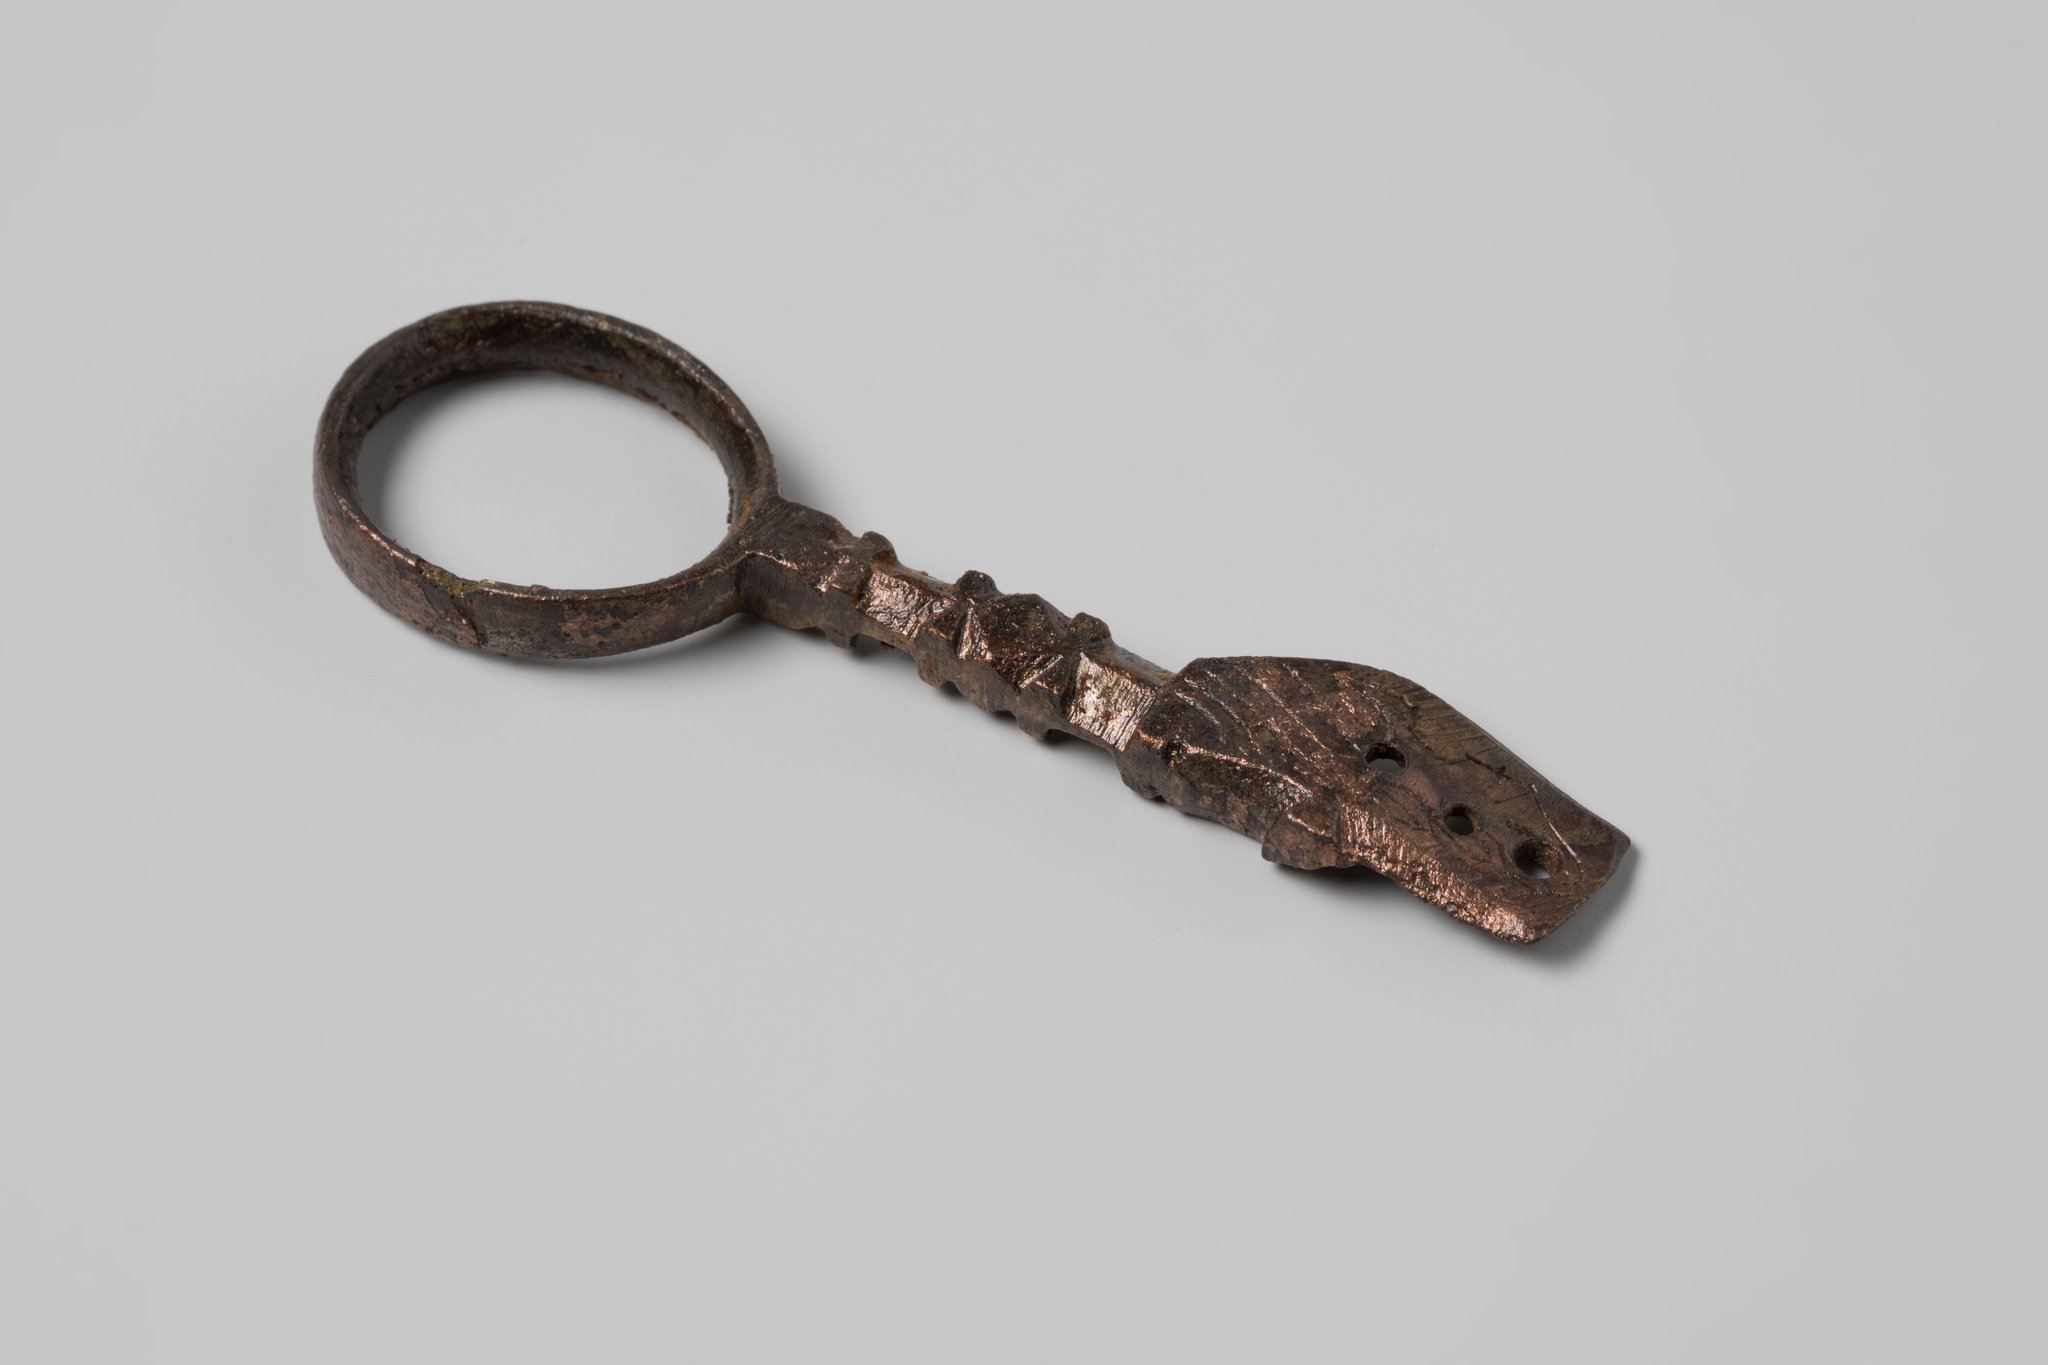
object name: pin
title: Speld uit het wrak van de Oost-Indiëvaarder Hollandia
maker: Anonymous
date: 1700-1743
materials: copper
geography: netherlands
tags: verenigde oostindische compagnie, hollandia (schip), annet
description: Tools and instruments, sewing and sailmaking, pin; fragm, handle: oval bow, square shaft with flat central diamond-shaped face on each side, ending in a flat blade-mount with 3 rivet-holes.